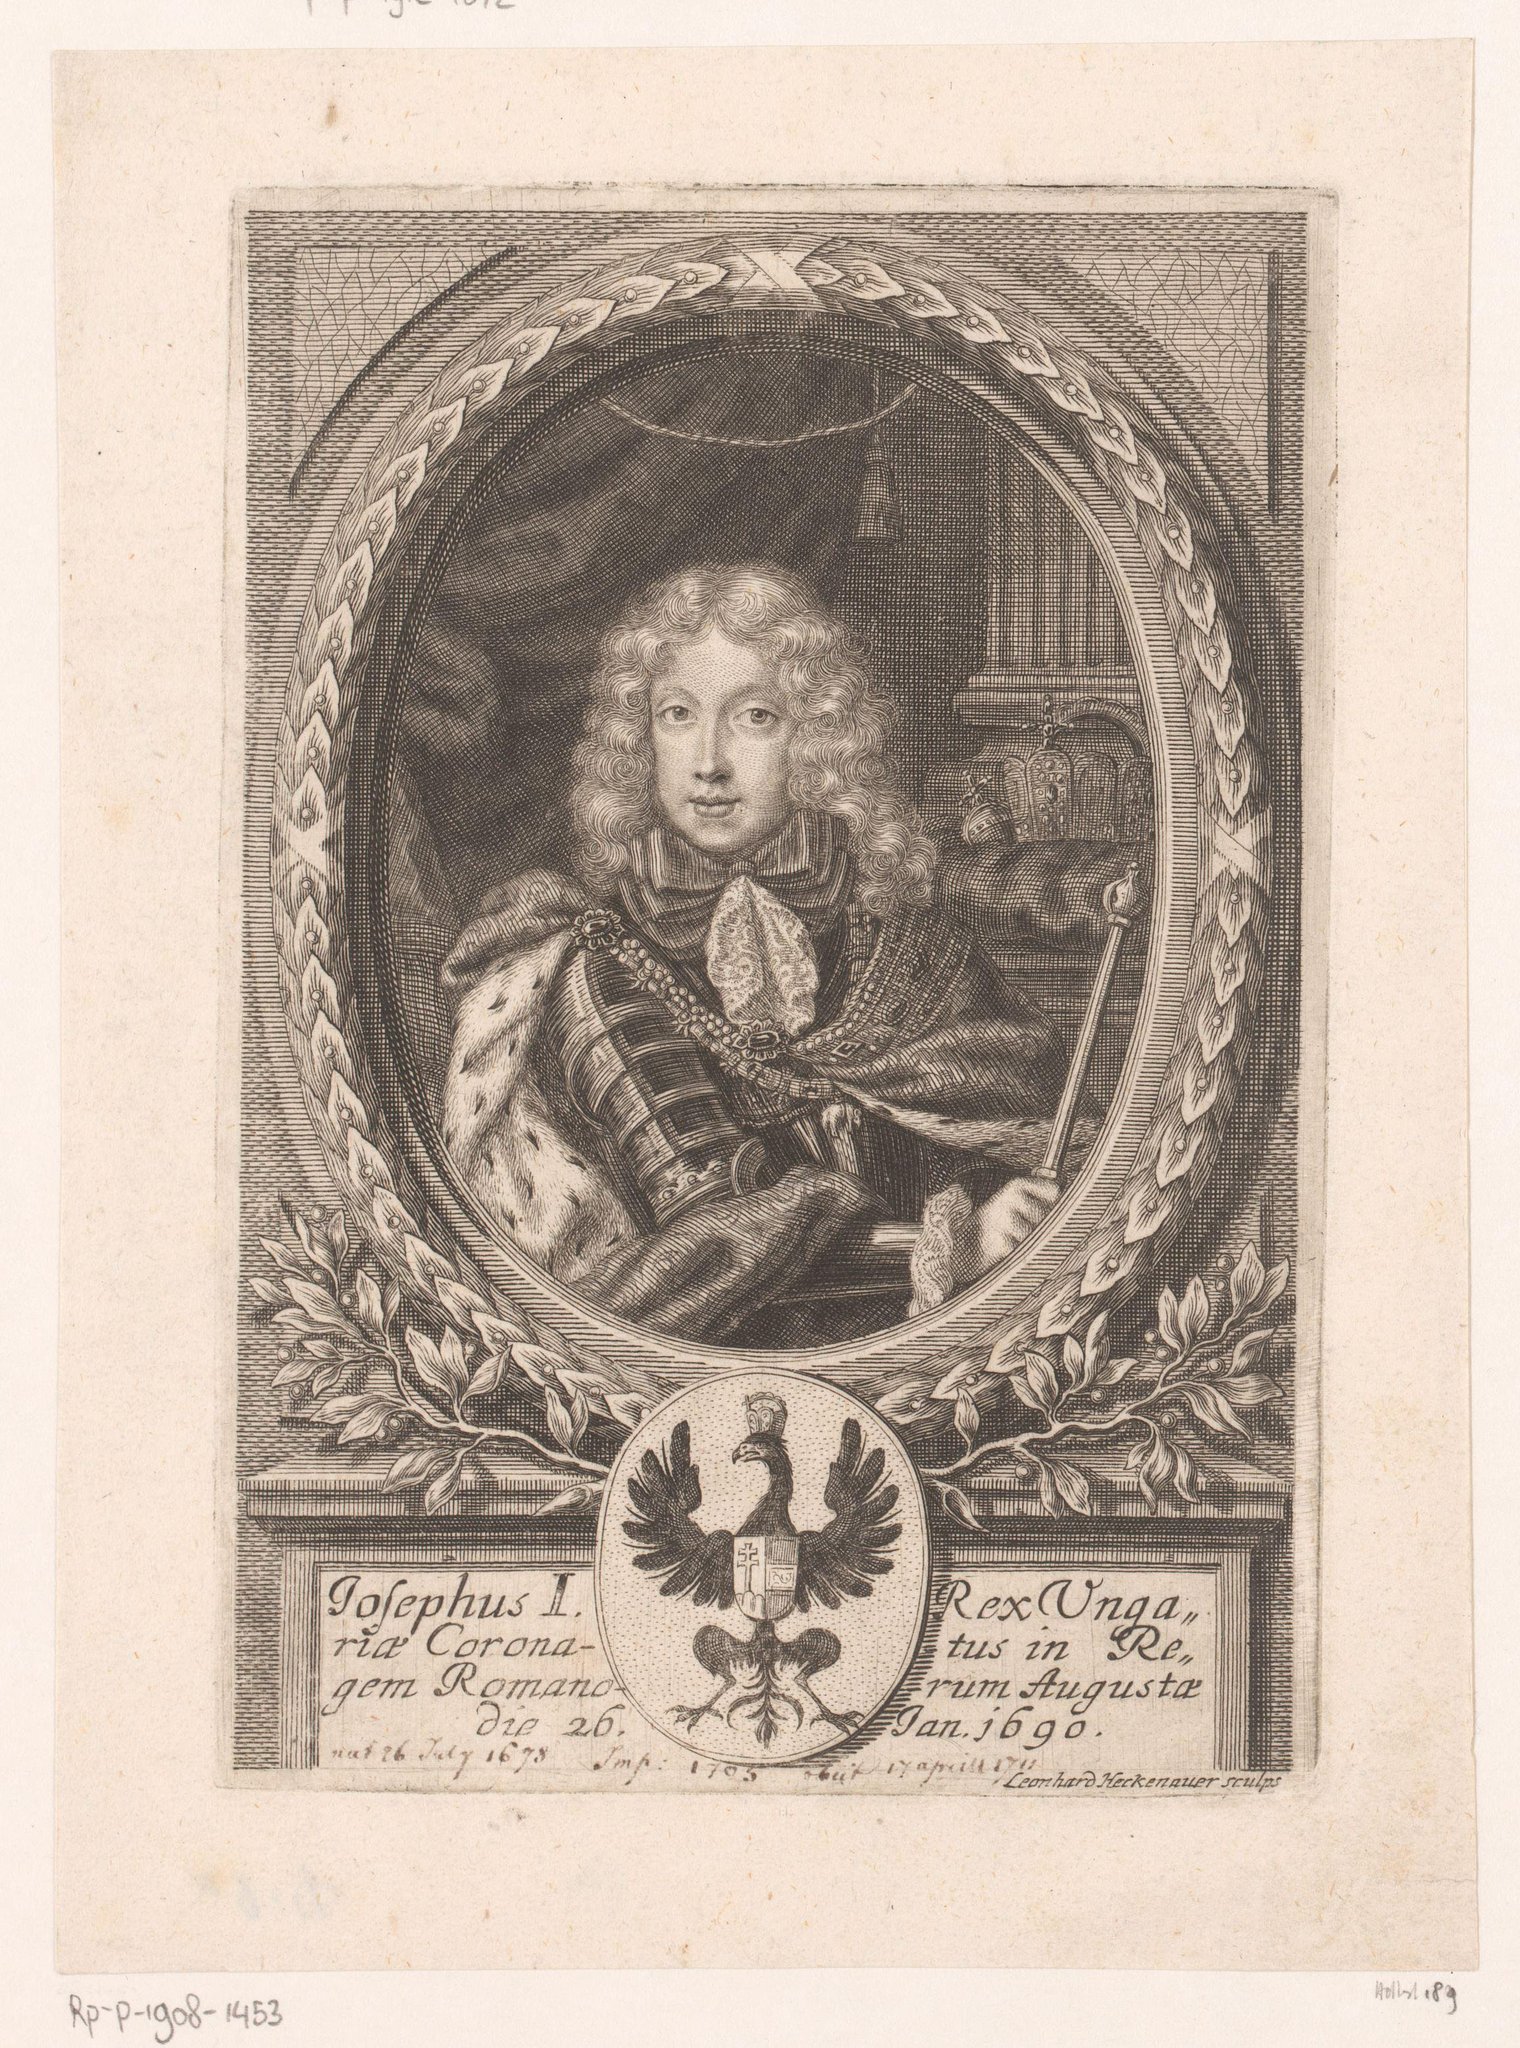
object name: print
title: Portret van Jozef I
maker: leonhard heckenauer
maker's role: print maker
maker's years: 1650-1704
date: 1690-1697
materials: paper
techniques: engraving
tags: vienna, jozef i (duits keizer), trees: laurel (branch, stick), trees: palm-tree (+ branch, stick), historical persons, ruler, sovereign, knighthood order of the golden fleece - insignia of a knighthood order, e.g.: badge, chain (with name of order), armorial bearing, heraldry, insignia and symbols of sovereignty (crown, diadem, sceptre, orb, seal, standard, cloak, pectoral)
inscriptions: inscription: ‘nat 26 July 1678 Imp: 1705 obit 17 april 1711’, collector's mark: Lugt 2228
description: Prent gebruikt voor: Thucelius, Christian Leonhard. Austria S.R.Imperio Conjux (...). Augsburg: Lorenz Kroniger, [1690]. Of prent gebruikt voor: Thulemarius, Heinrich Günther. Tractatio de Bulla aurea, argentea, plumbea et cerea in genere, nec non in specie de Aurea Bulla Caroli IV Imperatoris (...). Frankfurt am Main: Johann Melchior Bencard, 1697.